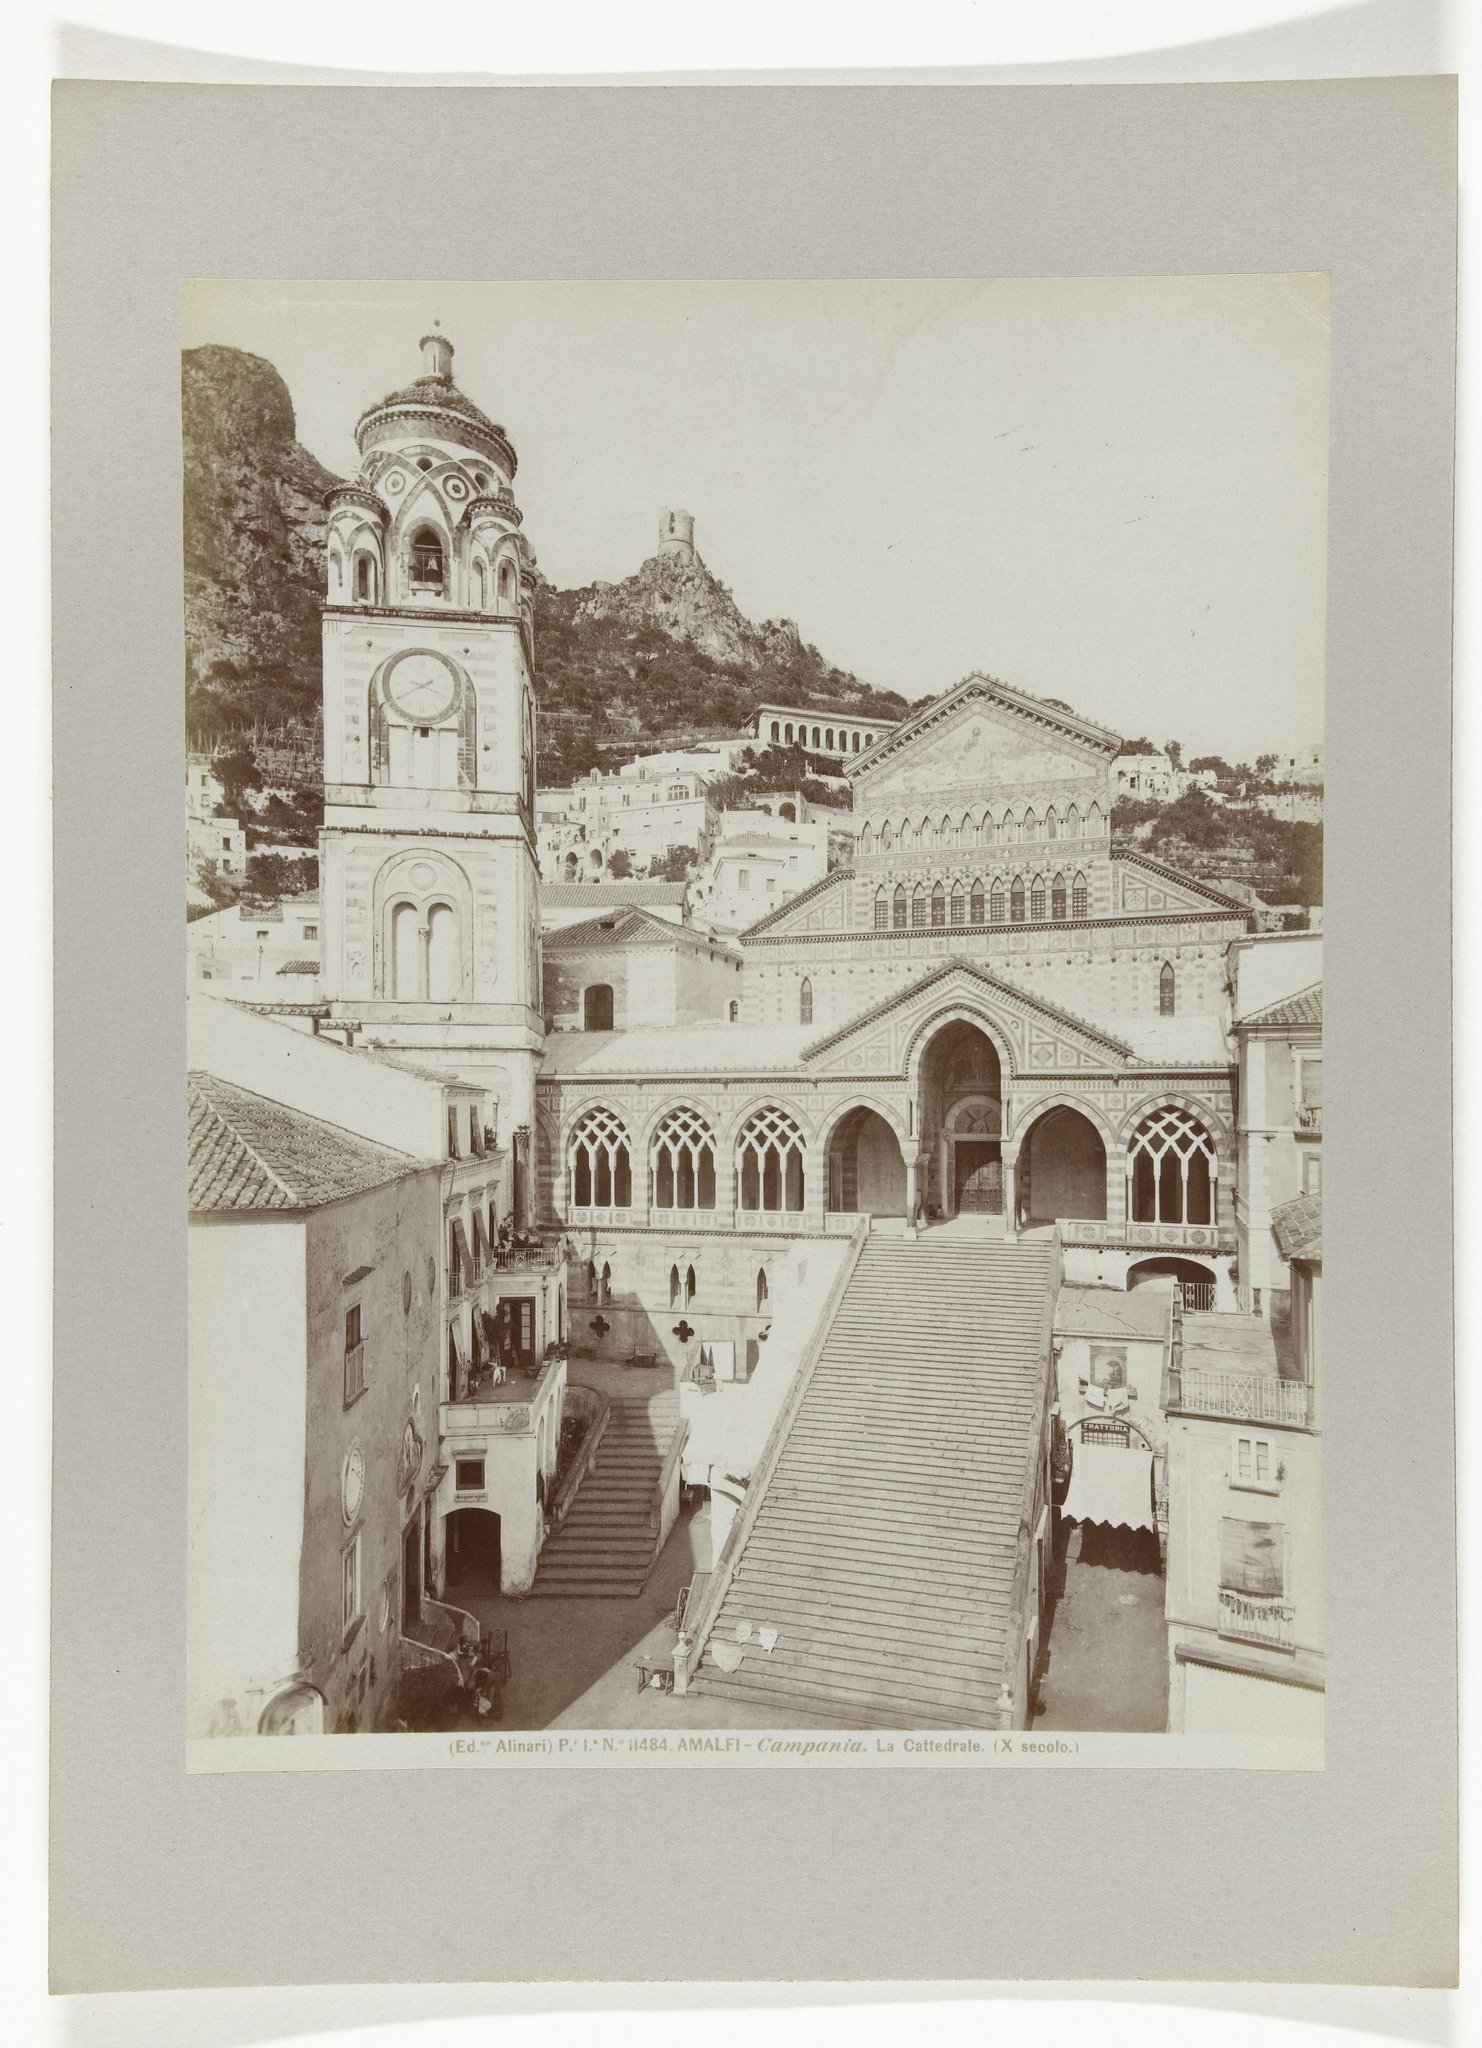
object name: photograph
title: P.e 1.a N.o 11484. AMALFI - Campania. La Cattedrale. (X secolo.)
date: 1880-1895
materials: cardboard, paper, photographic support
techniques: albumen print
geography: florence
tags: kathedraal van amalfi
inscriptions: number: ‘64.’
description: Kathedraal van Amalfi in de regio Campania, gebouwd in de 10e eeuw.